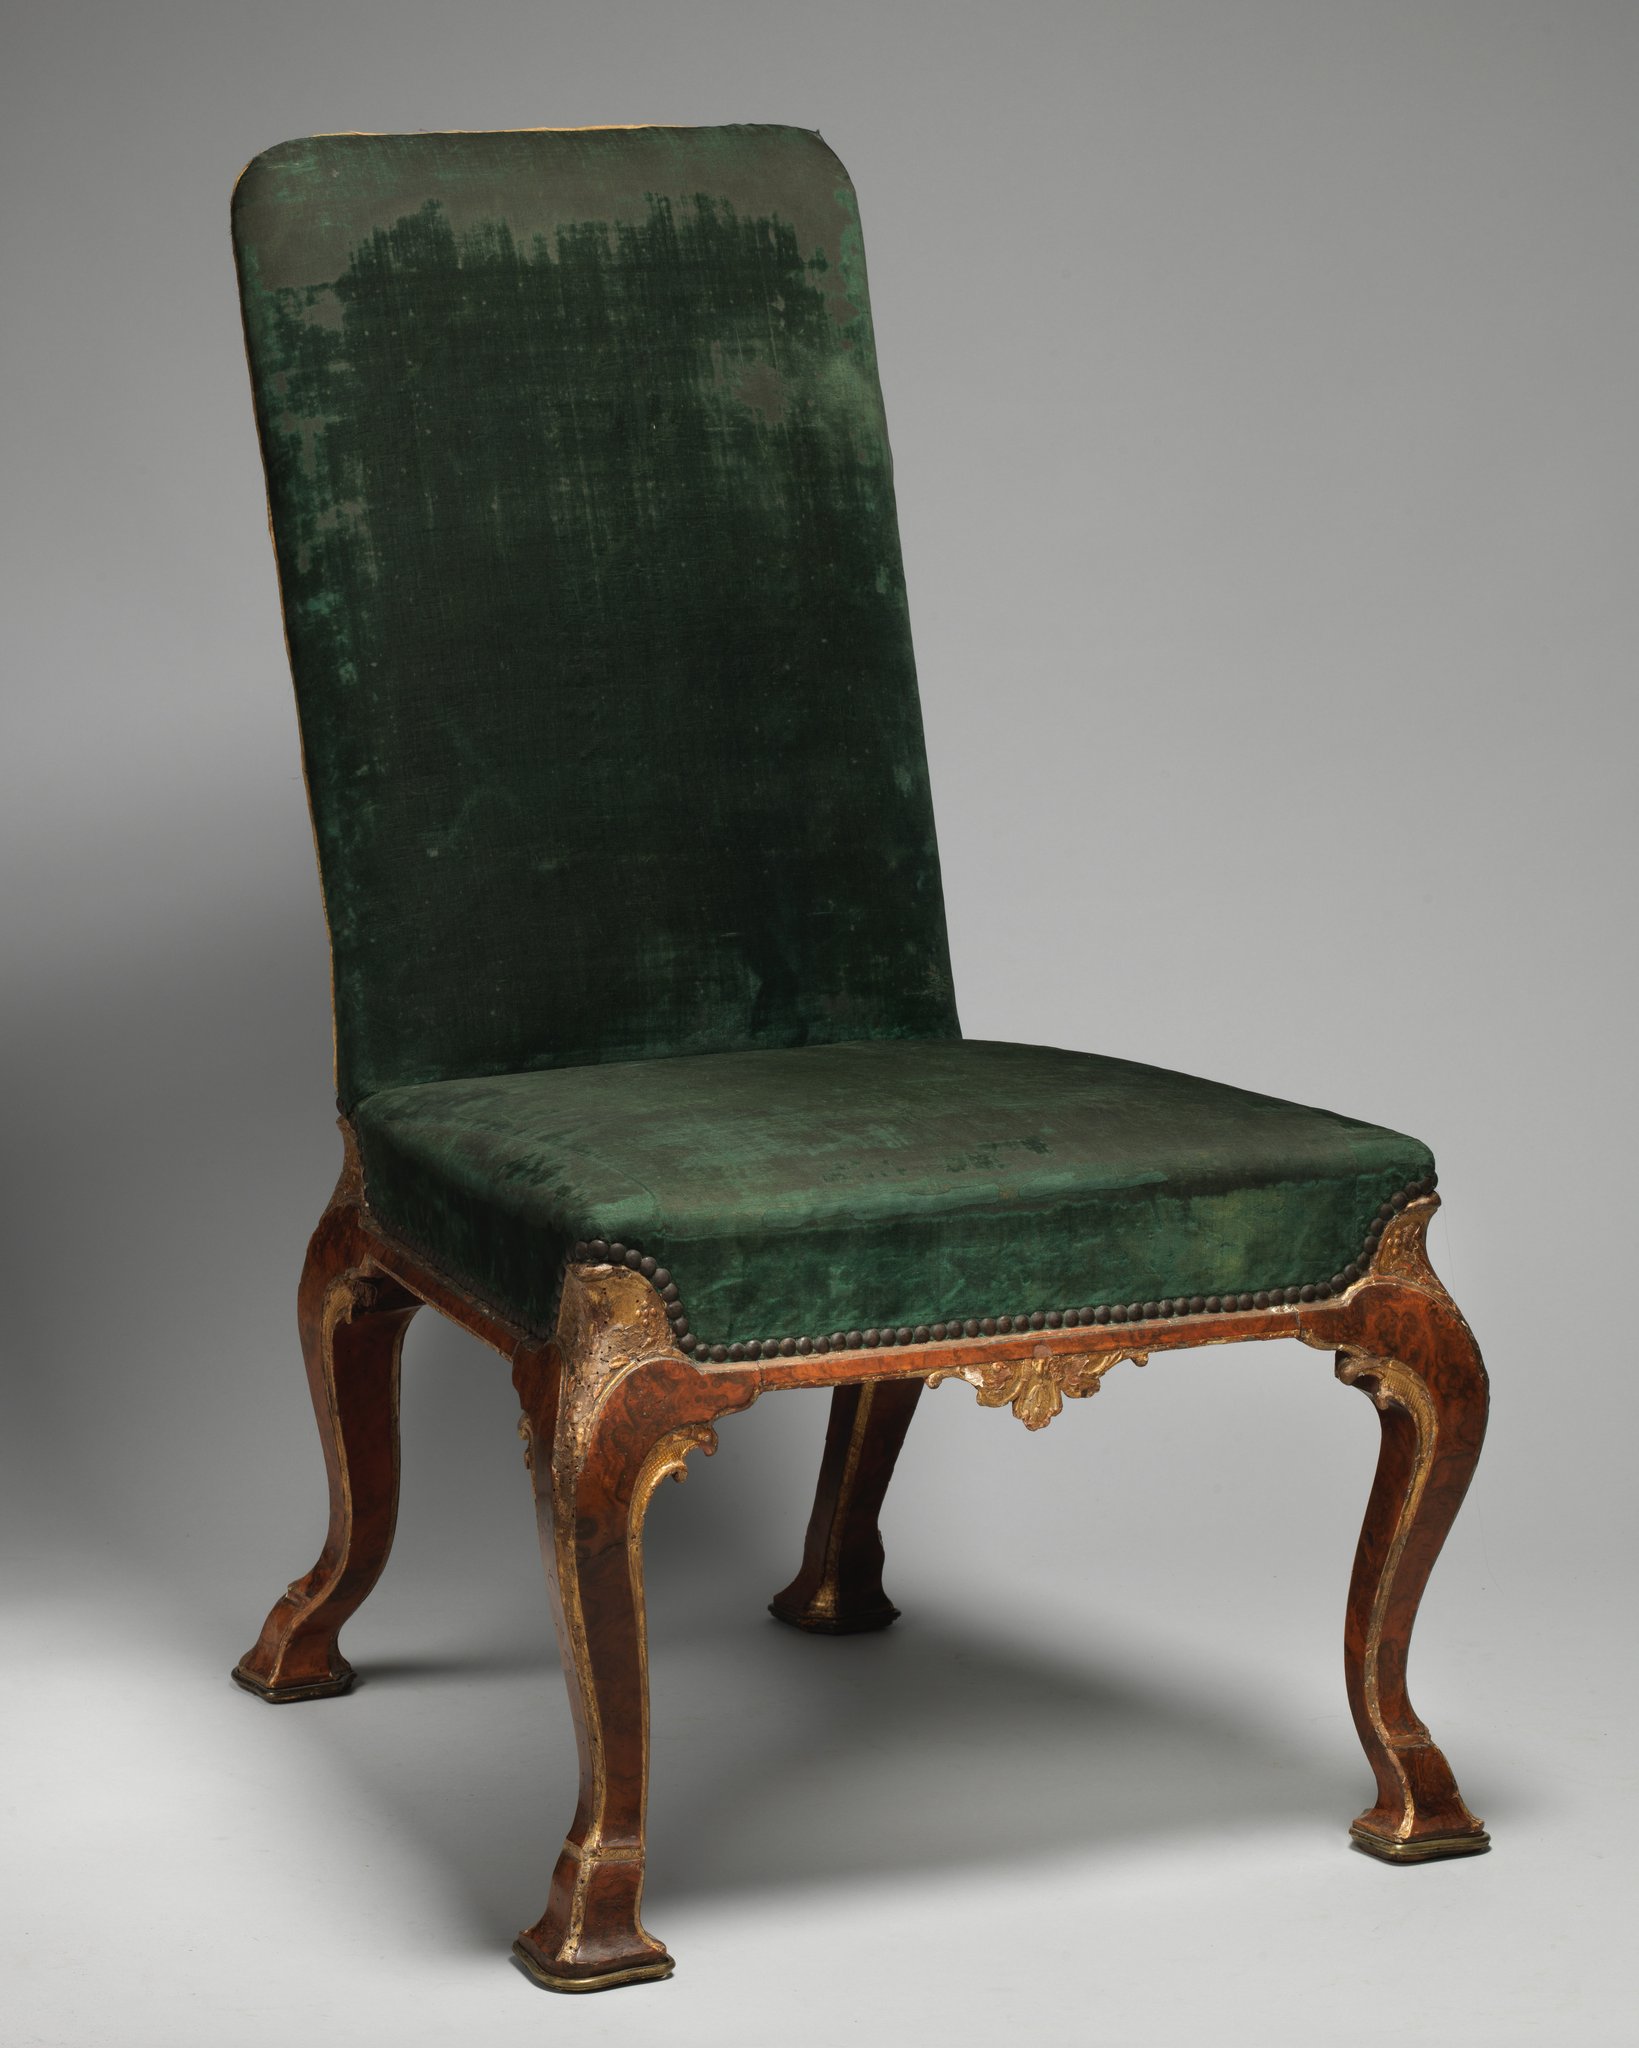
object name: side chair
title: Side chair (one of a pair)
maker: richard roberts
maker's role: maker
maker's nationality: british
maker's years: 1714-1729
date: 1715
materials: wood, gilt, silk, velvet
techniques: veneering